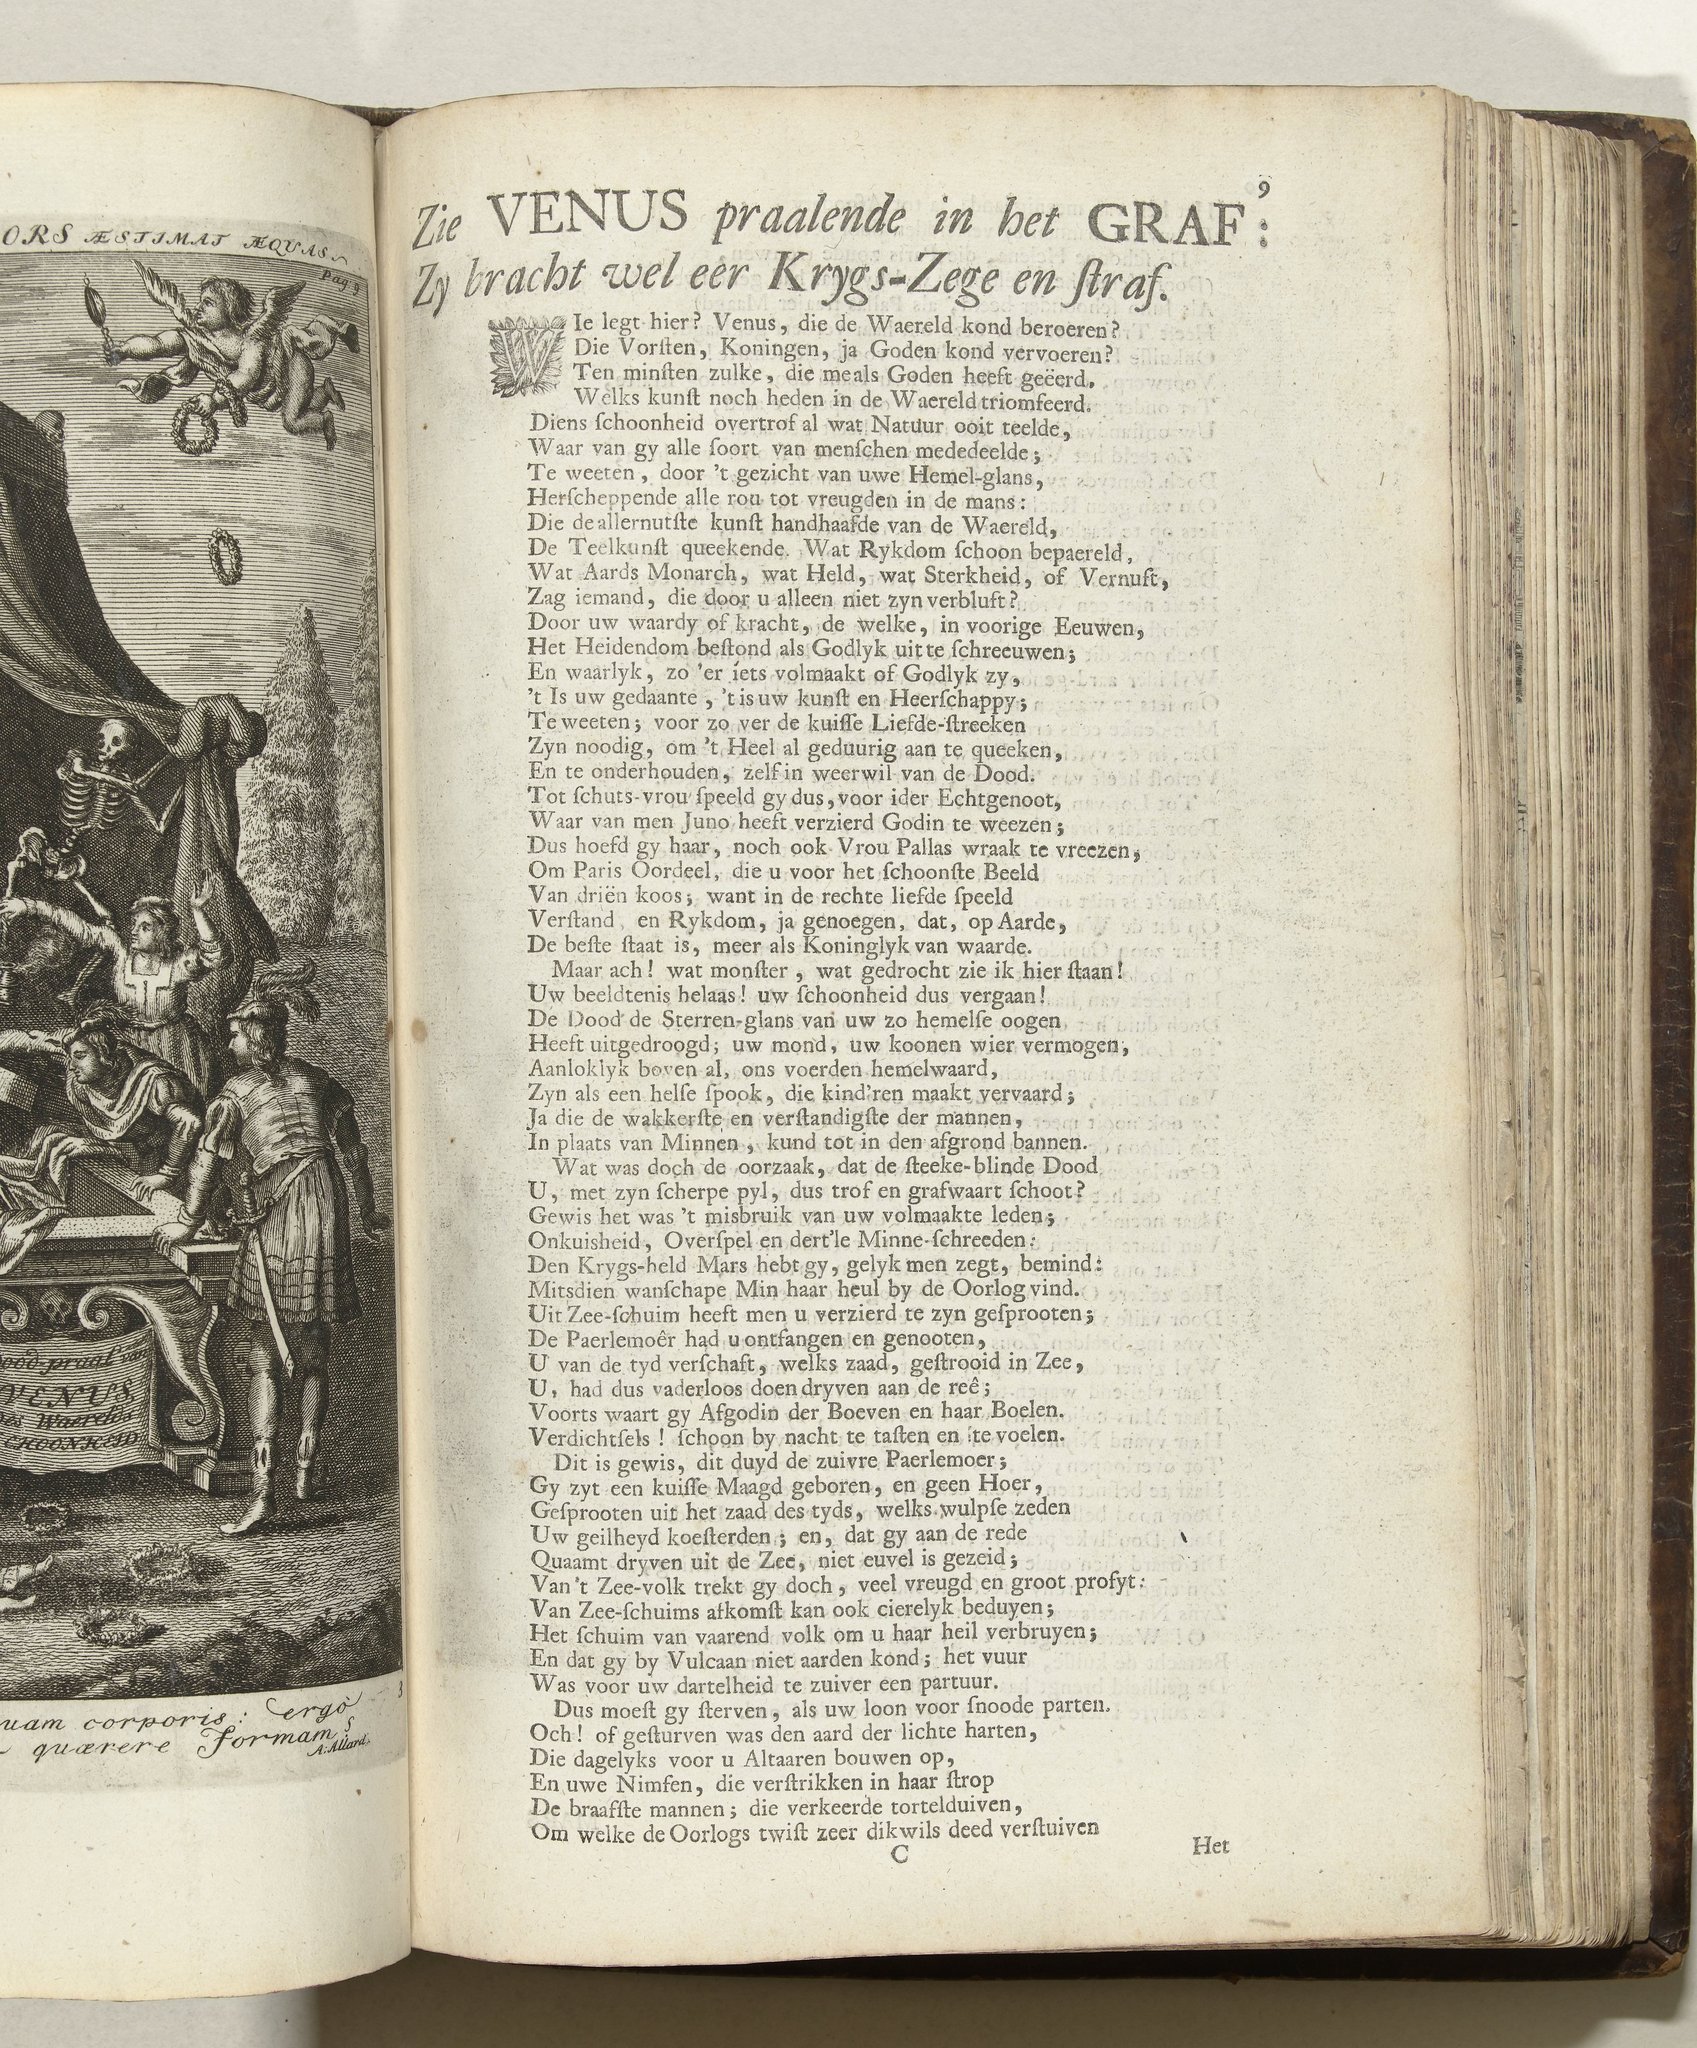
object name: text sheet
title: Zie Venus praalende in het Graf: Zy bracht wel eer Krygs-Zege en straf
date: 1707-1708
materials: paper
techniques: letterpress printing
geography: amsterdam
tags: spaanse successieoorlog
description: Tekstblad met op beide bladzijden een vers behorend bij de prent met de allegorie waarin omstanders het geraamte in het geopende graf van de godin Venus bekijken, ca. 1707-1708. Onderdeel van: De Standvastige Monarchye des Doods, een reeks van 8 oude platen met verzen aangepast voor gebruik als spotprenten op de Fransen in de context van de Spaanse Successieoorlog. Onderdeel van het prentwerk uitgegeven onder de verzameltitel 't Lust-Hof van Momus met de gebundelde series van spotprenten tijdens de jaren 1701-1713 van de Spaanse Successieoorlog.